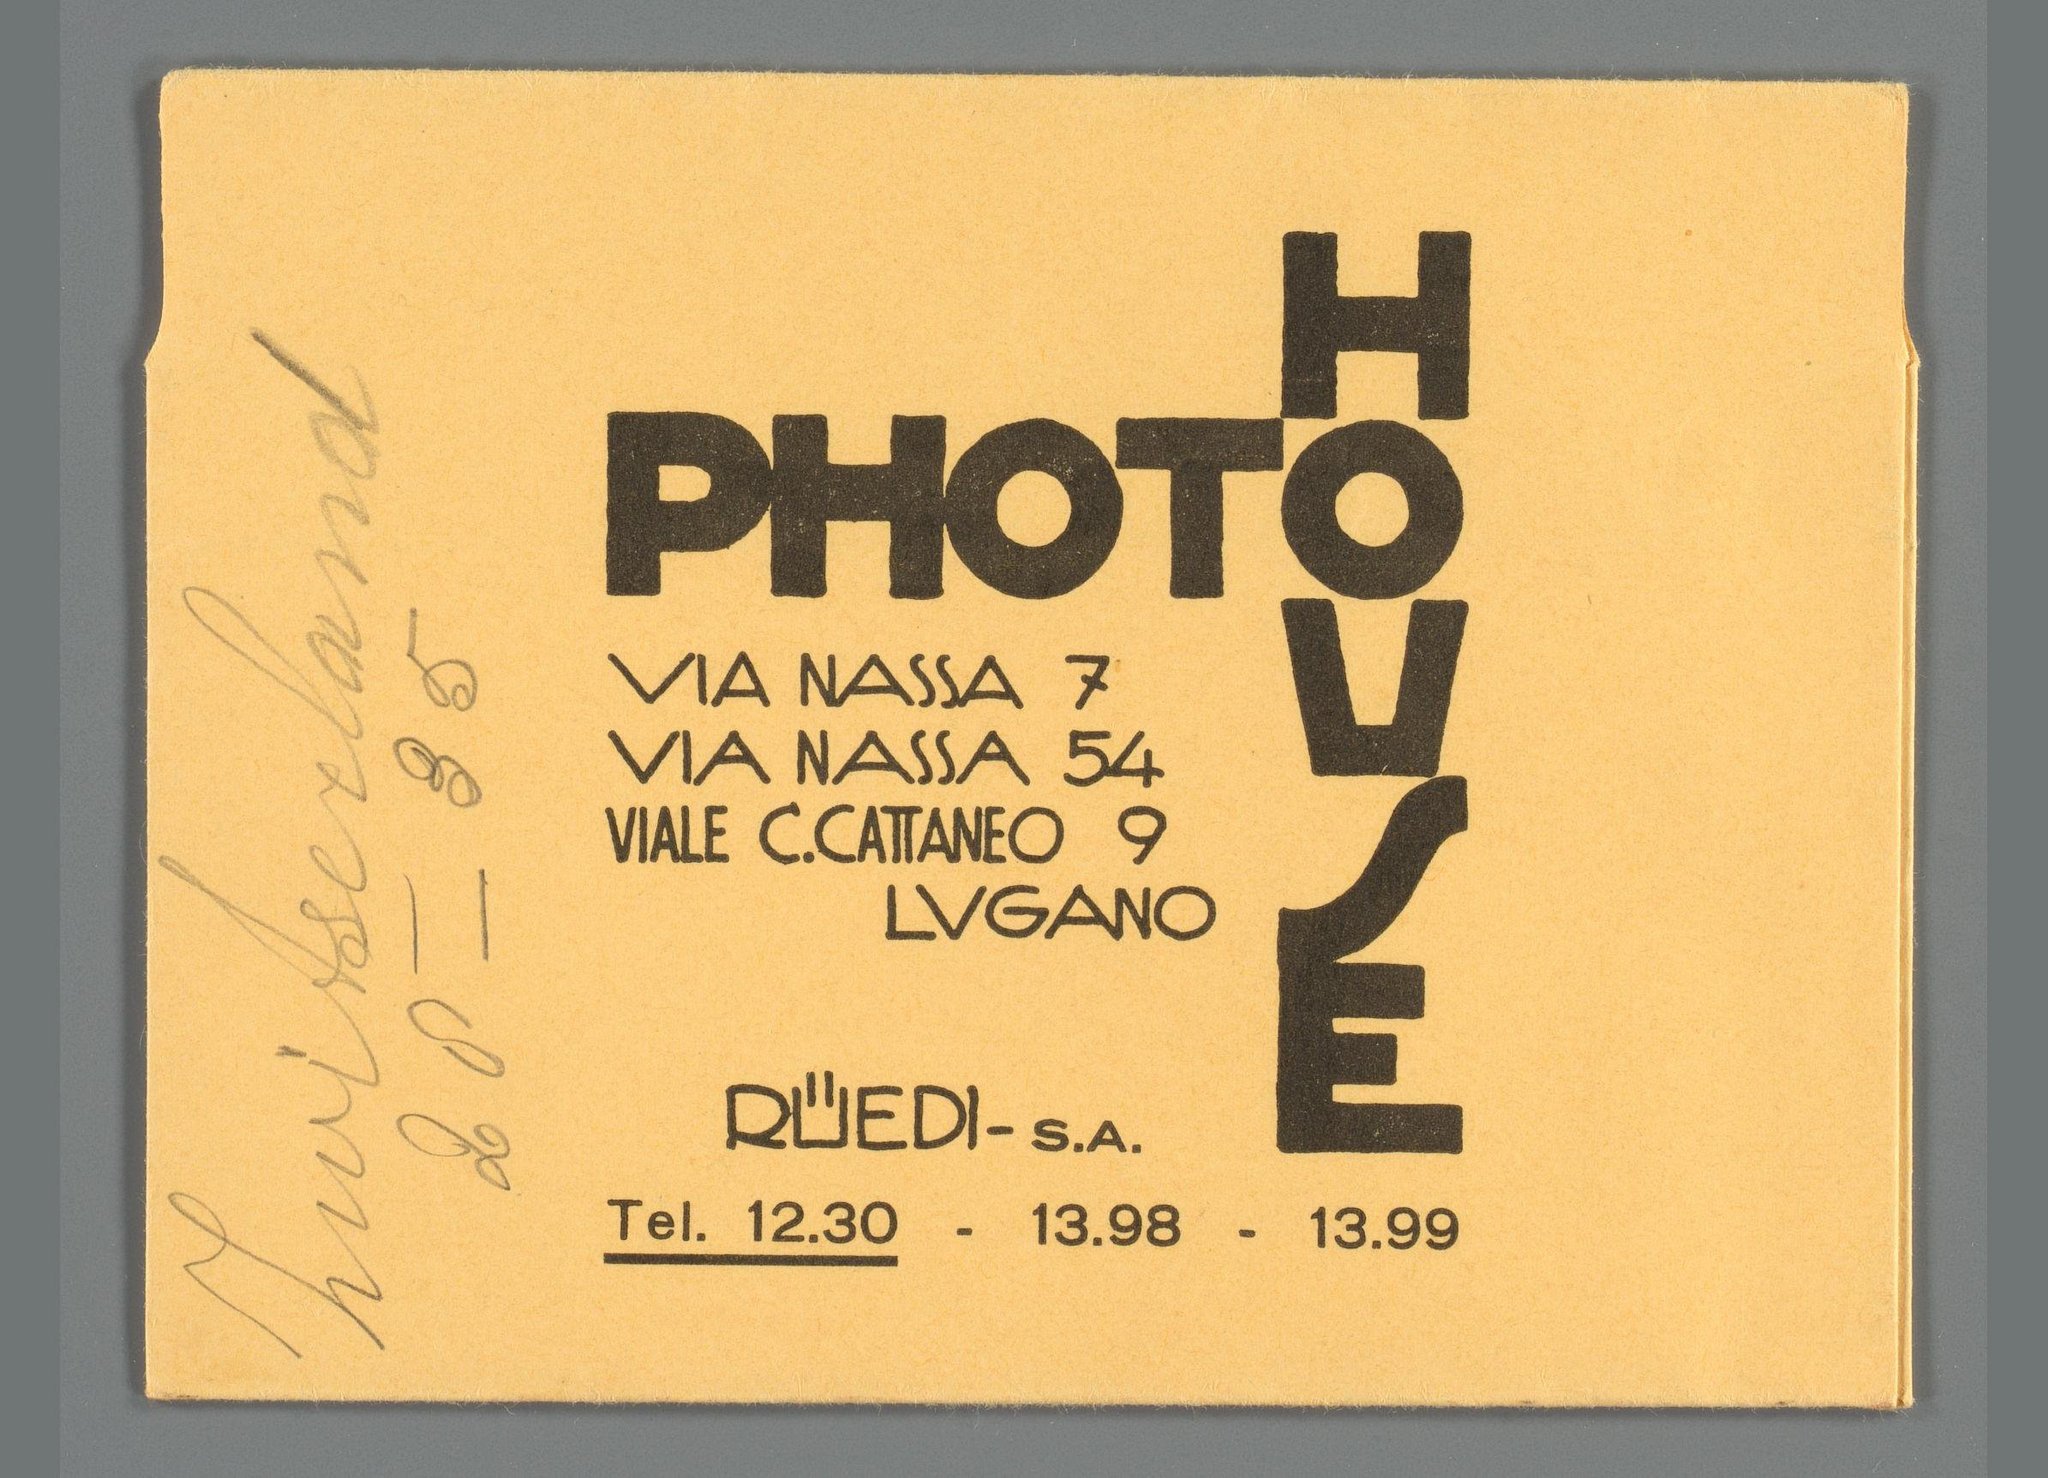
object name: photomap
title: Map voor negatieven van Photo House Rüedi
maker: Anonymous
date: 1930-1935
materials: paper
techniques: letterpress printing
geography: lugano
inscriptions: inscription: ‘Zwitserland/ 28-35’